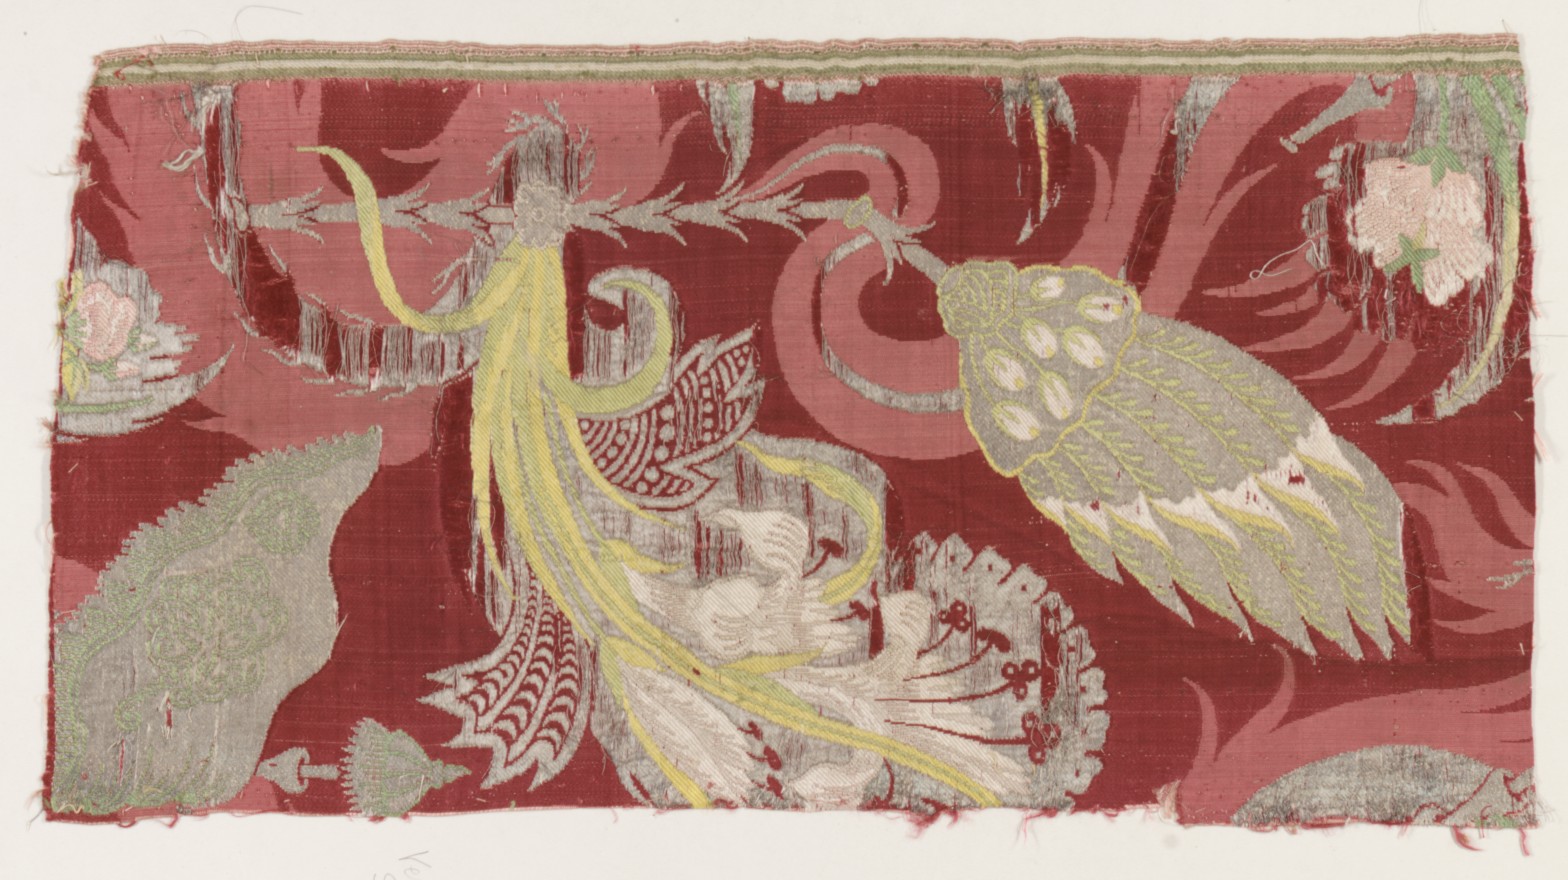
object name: fragment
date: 1701-1733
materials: metal thread, silk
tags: flowers